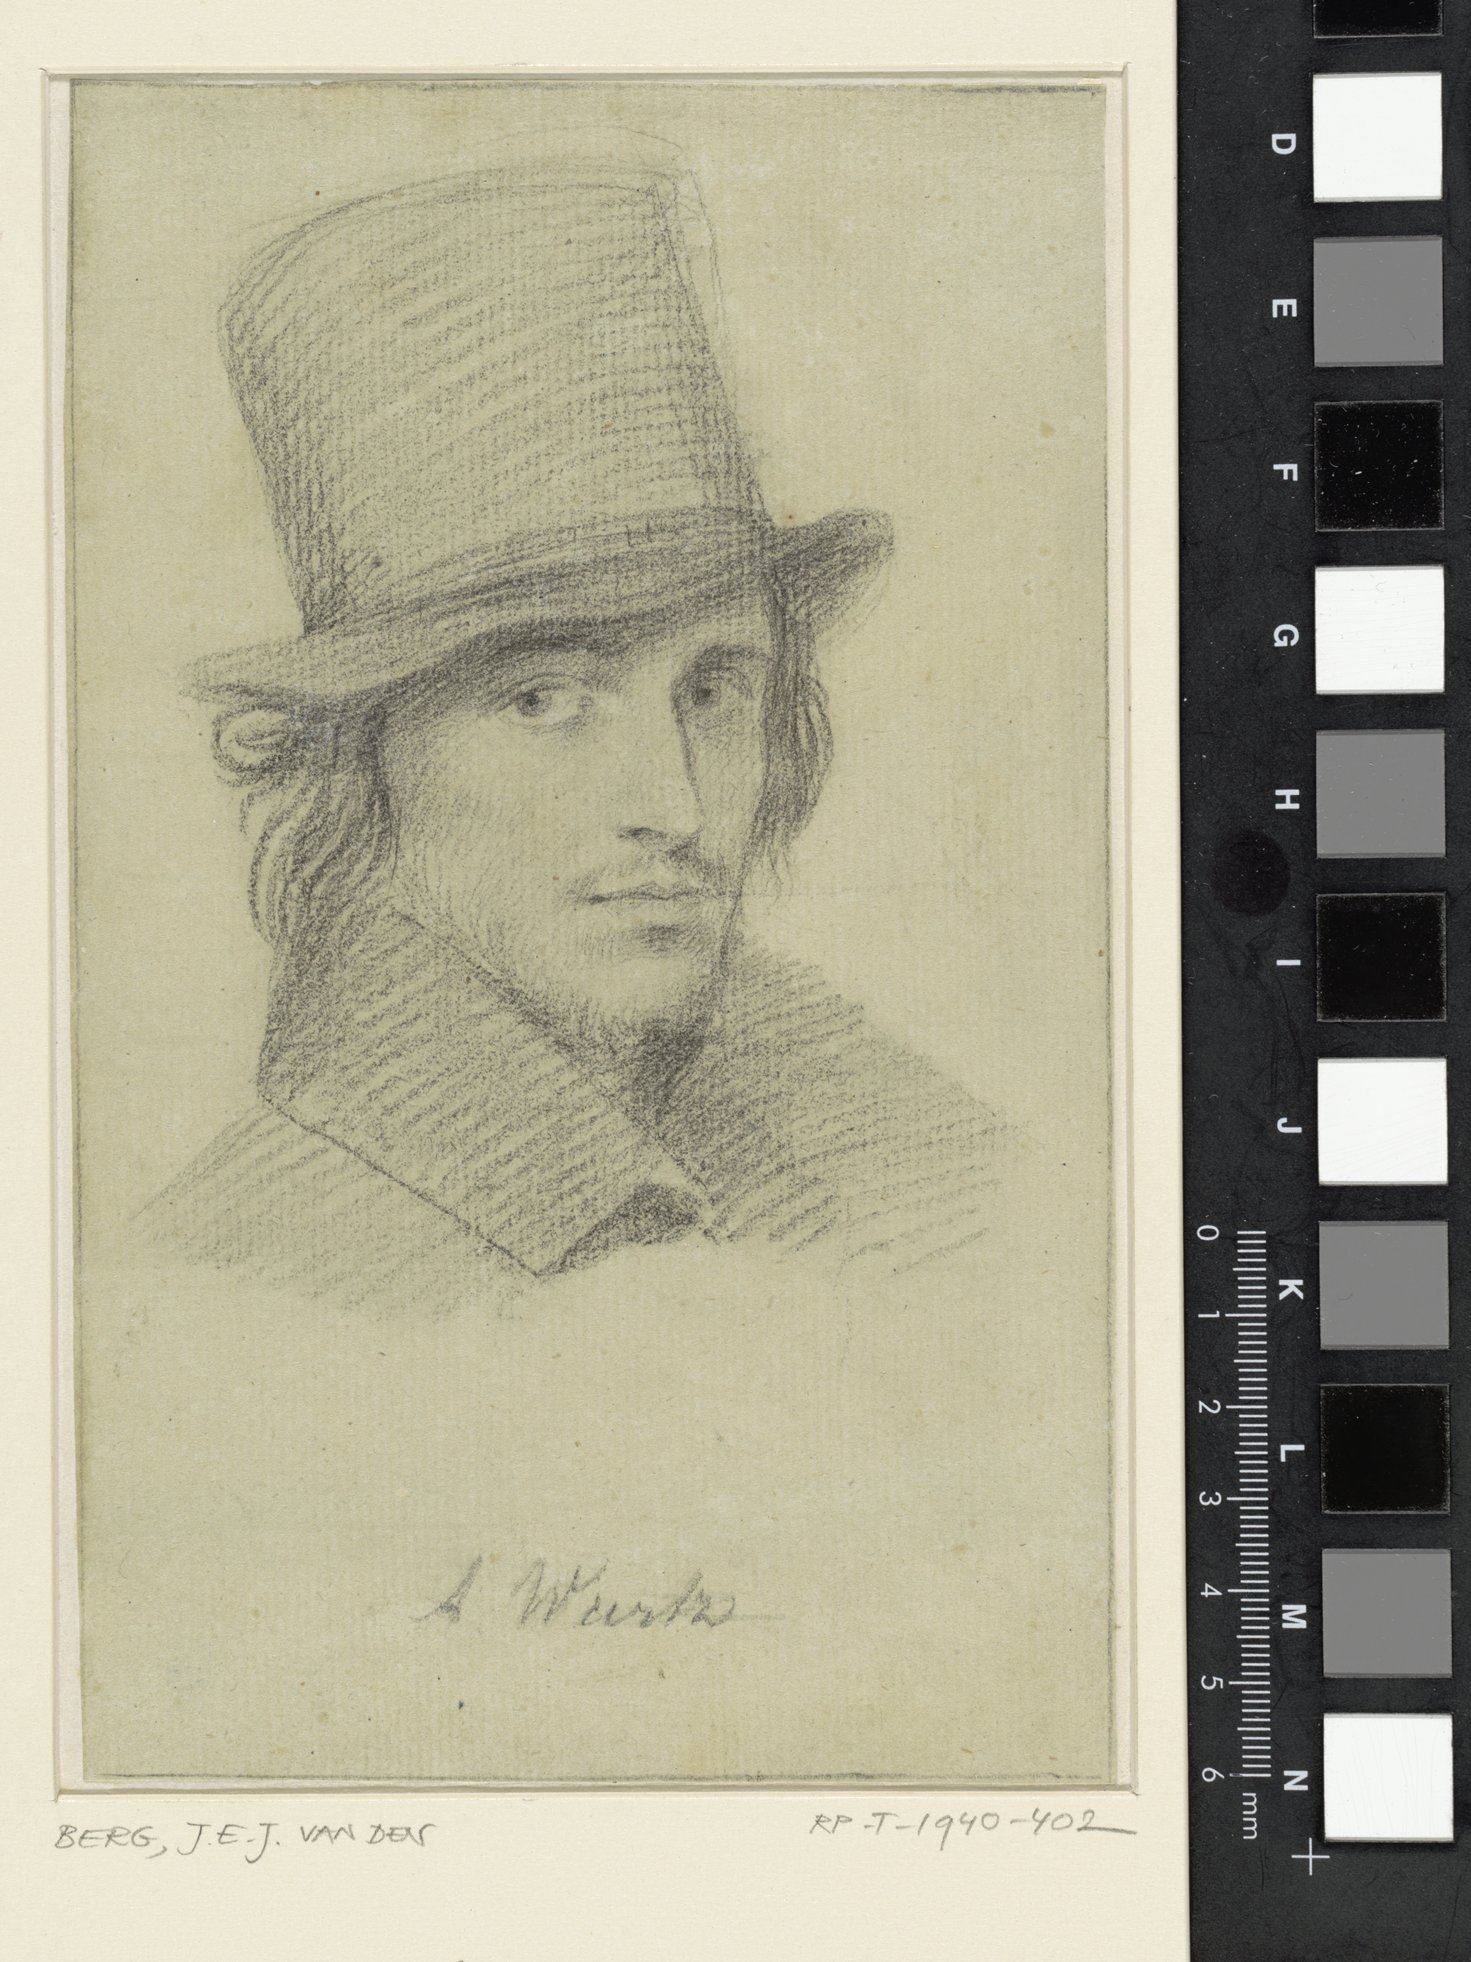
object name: drawing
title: Portret van Antoine Joseph Wiertz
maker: jacobus everhardus josephus van den berg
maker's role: draughtsman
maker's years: 1802-1861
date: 1812-1861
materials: chalk, paper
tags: brussels, antoine joseph wiertz, portrait, self-portrait of sculptor, historical persons, portrait, self-portrait of painter, portrait, self-portrait of artist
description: Portret van de schilder en beeldhouwer Antoine Joseph Wiertz.